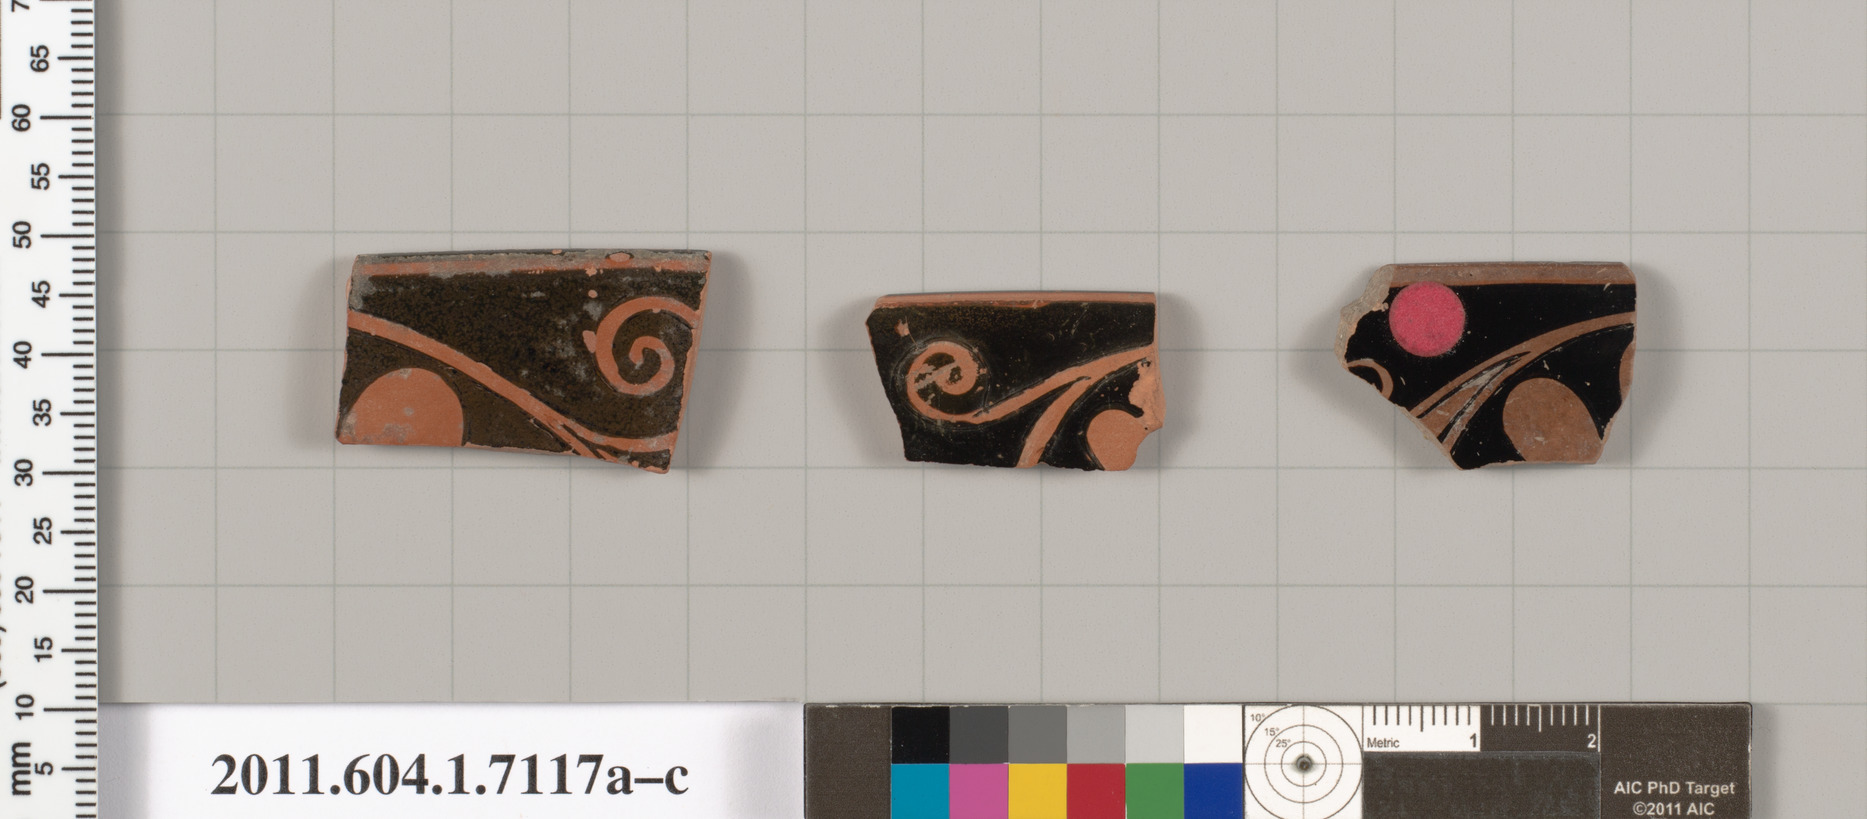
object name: kylix fragment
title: Terracotta fragments of kylikes (drinking cups)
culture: greek, attic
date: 500-480 BCE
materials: terracotta